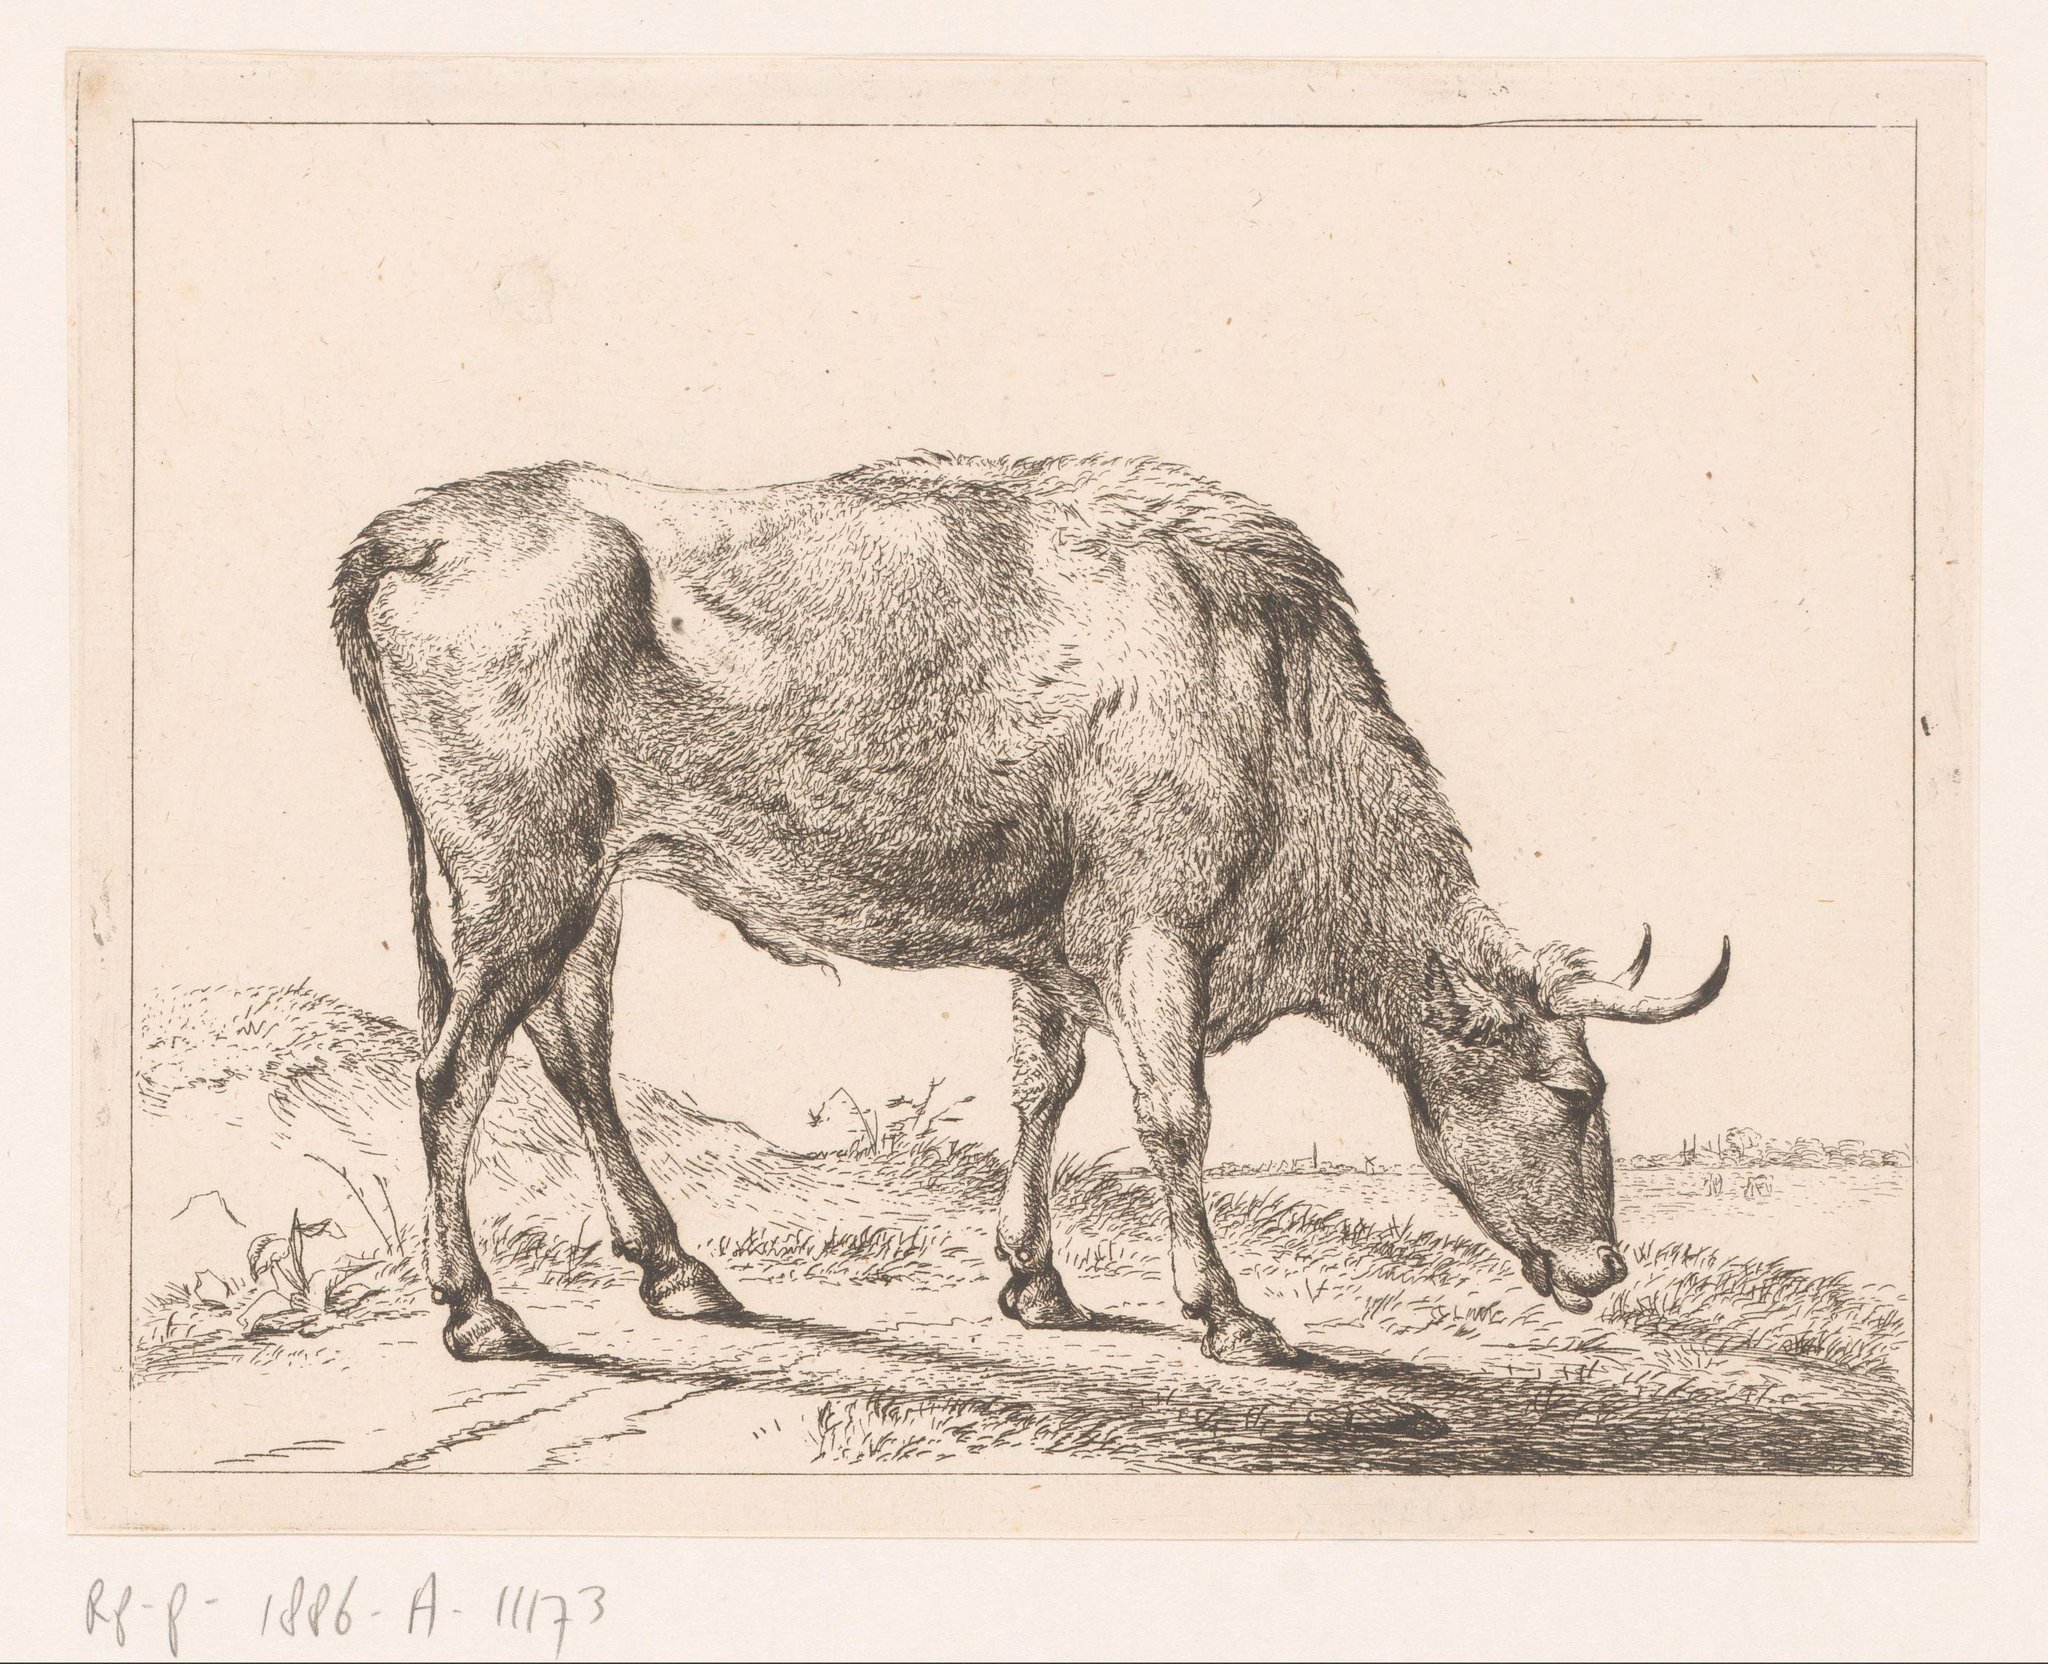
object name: print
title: Stier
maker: hendrik willem schweickhardt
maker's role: draughtsman, painter, print maker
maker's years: 1746-1797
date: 1788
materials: paper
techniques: etching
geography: england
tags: bull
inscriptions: collector's mark: Lugt 2228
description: Behoort tot een serie van acht prenten met verschillende dieren.